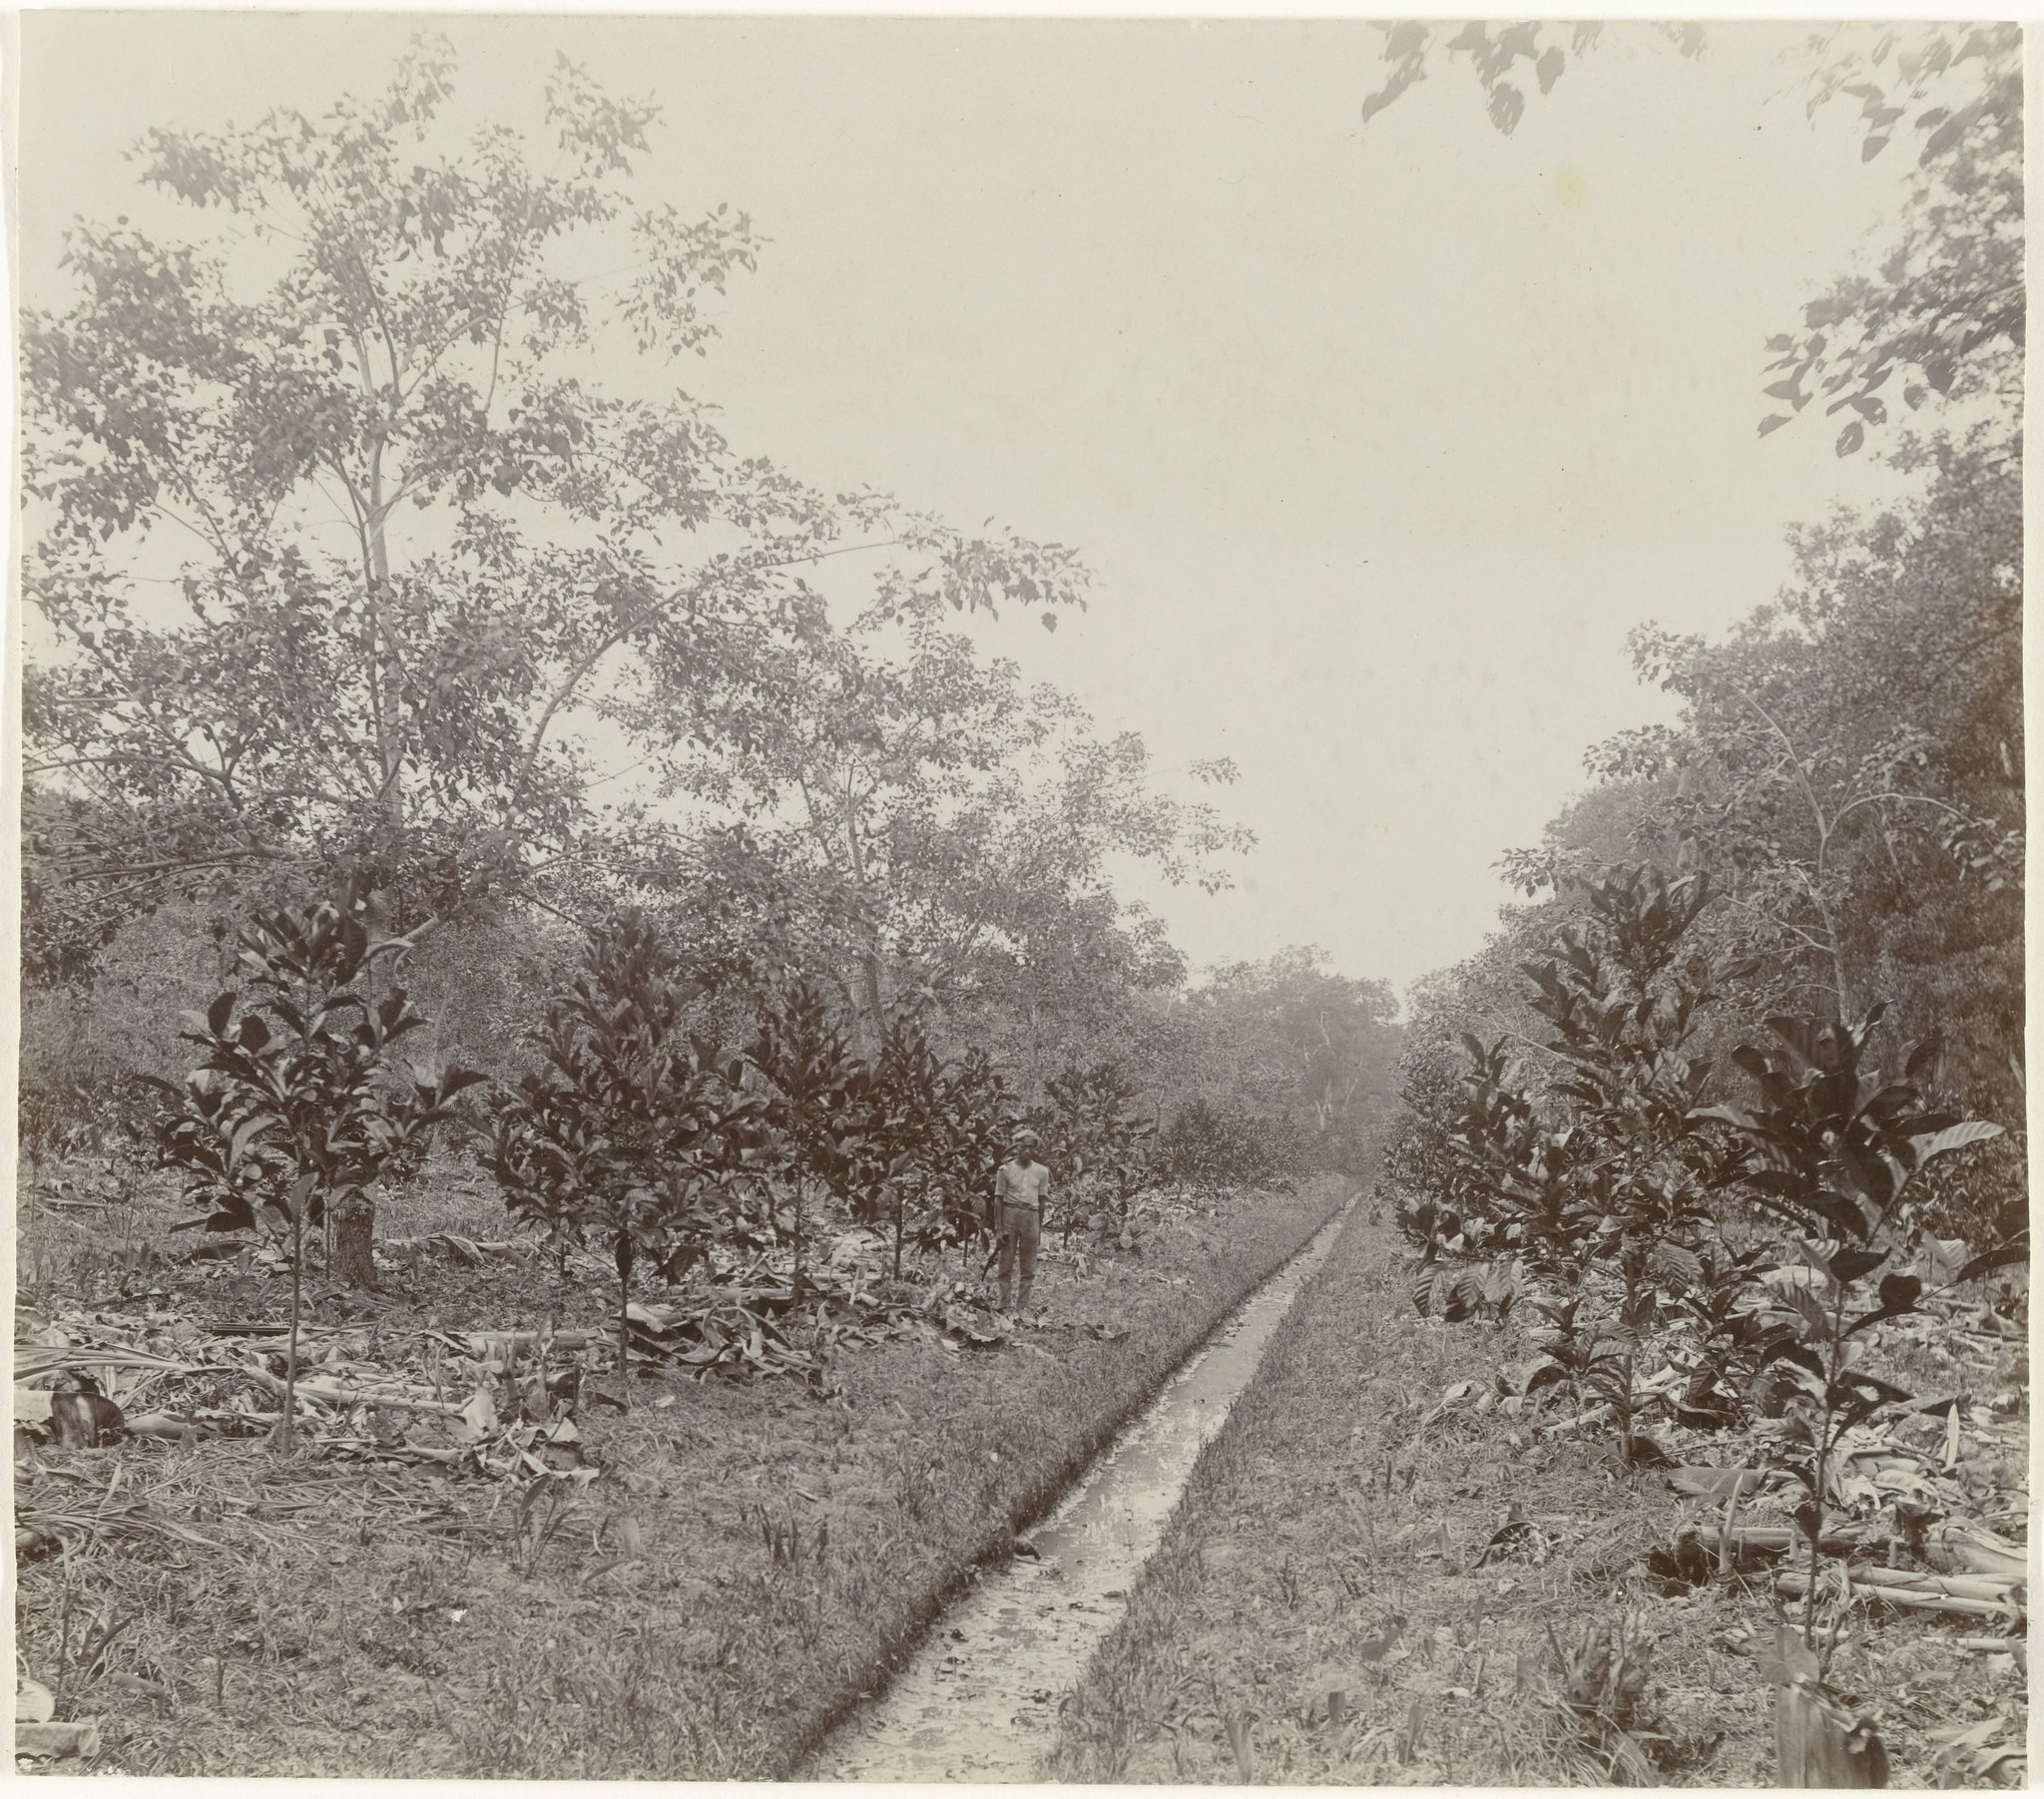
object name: photograph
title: Plantage Johanna-Catharina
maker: theodoor brouwers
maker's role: amateurfotograaf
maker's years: 1874-1932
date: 1918-1932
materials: photographic support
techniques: photography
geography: suriname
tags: amsterdam, theodoor brouwers, suriname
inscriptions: label: ‘Johanna Catharina. Veld No 22. Jonge koffie, aanplant Maart 1918. De schaduw van bananen is pas opgeruimd.’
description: In de periode 1911-1932 woonde op plantage Accaribo in Suriname de familie Brouwers van wie de foto's afkomstig zijn. Rond 1910 vond Theodoor Brouwers werk op plantage Accaribo. In 1929 werd hij eigenaar van de plantage.